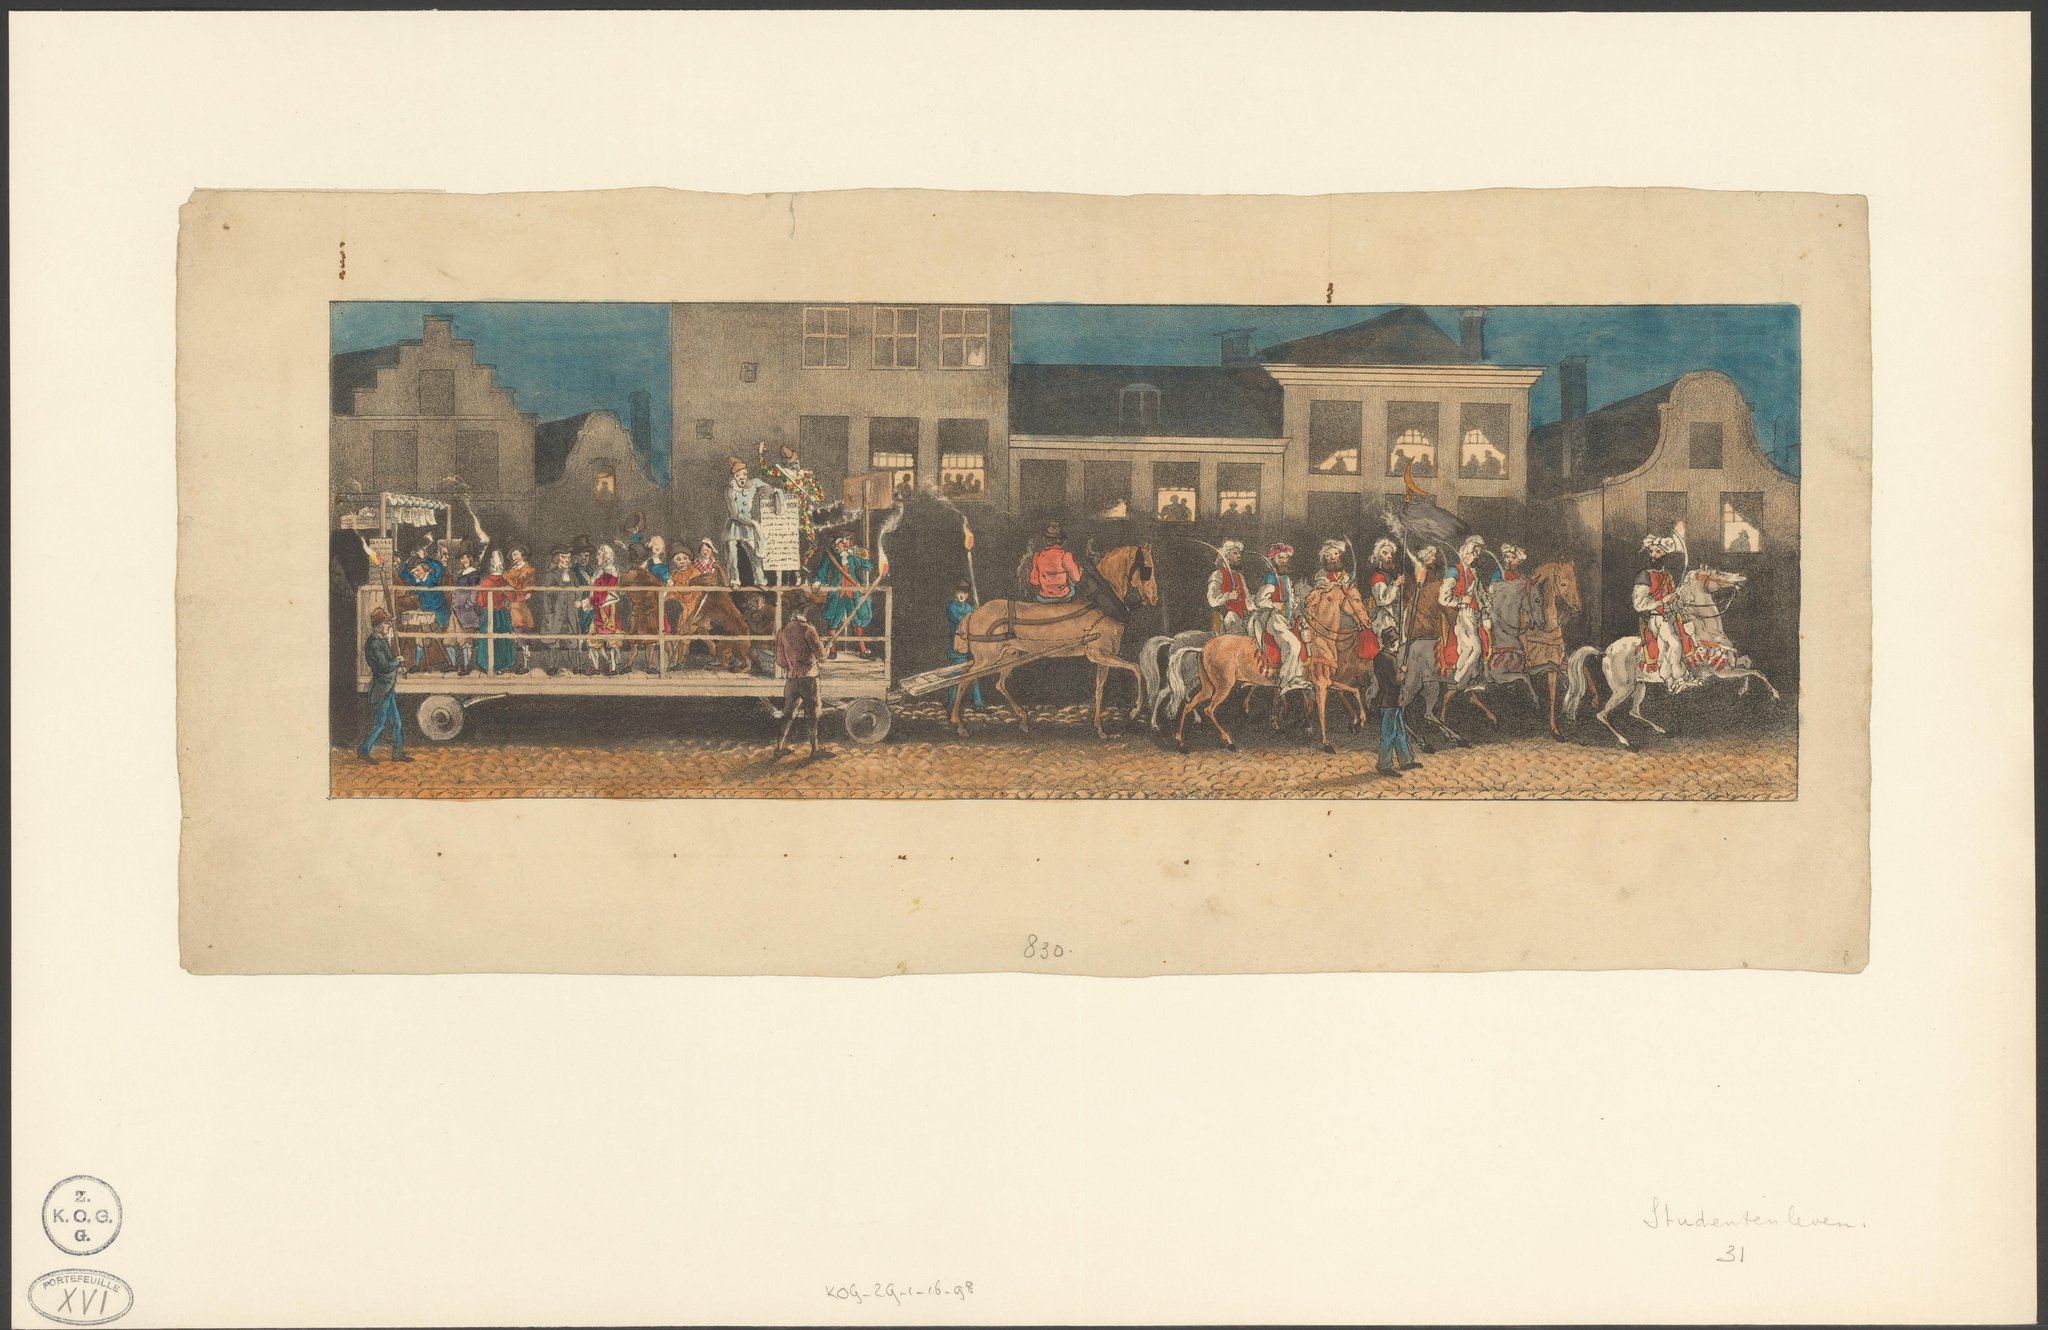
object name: print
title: Optocht in maskerade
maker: johannes paulus houtman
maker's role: bookseller, print maker, printer, publisher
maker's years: 1803-1845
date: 1829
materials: paper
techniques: hand coloring, lithograph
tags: students' pageant, costumes used in pageants, utrecht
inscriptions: stamp, collector's mark: Lugt 1641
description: Optocht in maskerade van Utrechtse studenten ter viering van de Dies Natalis van de universiteit van Utrecht op 26 maart 1829. Stoet met een groep ruiters verkleed als Arabieren met kromsabels gevolgd door een praalwagen. Onderwerpsrubrieken binnen de Atlas Zeden en Gewoonten: Onderwijs en Wetenschappen, Studentenleven.